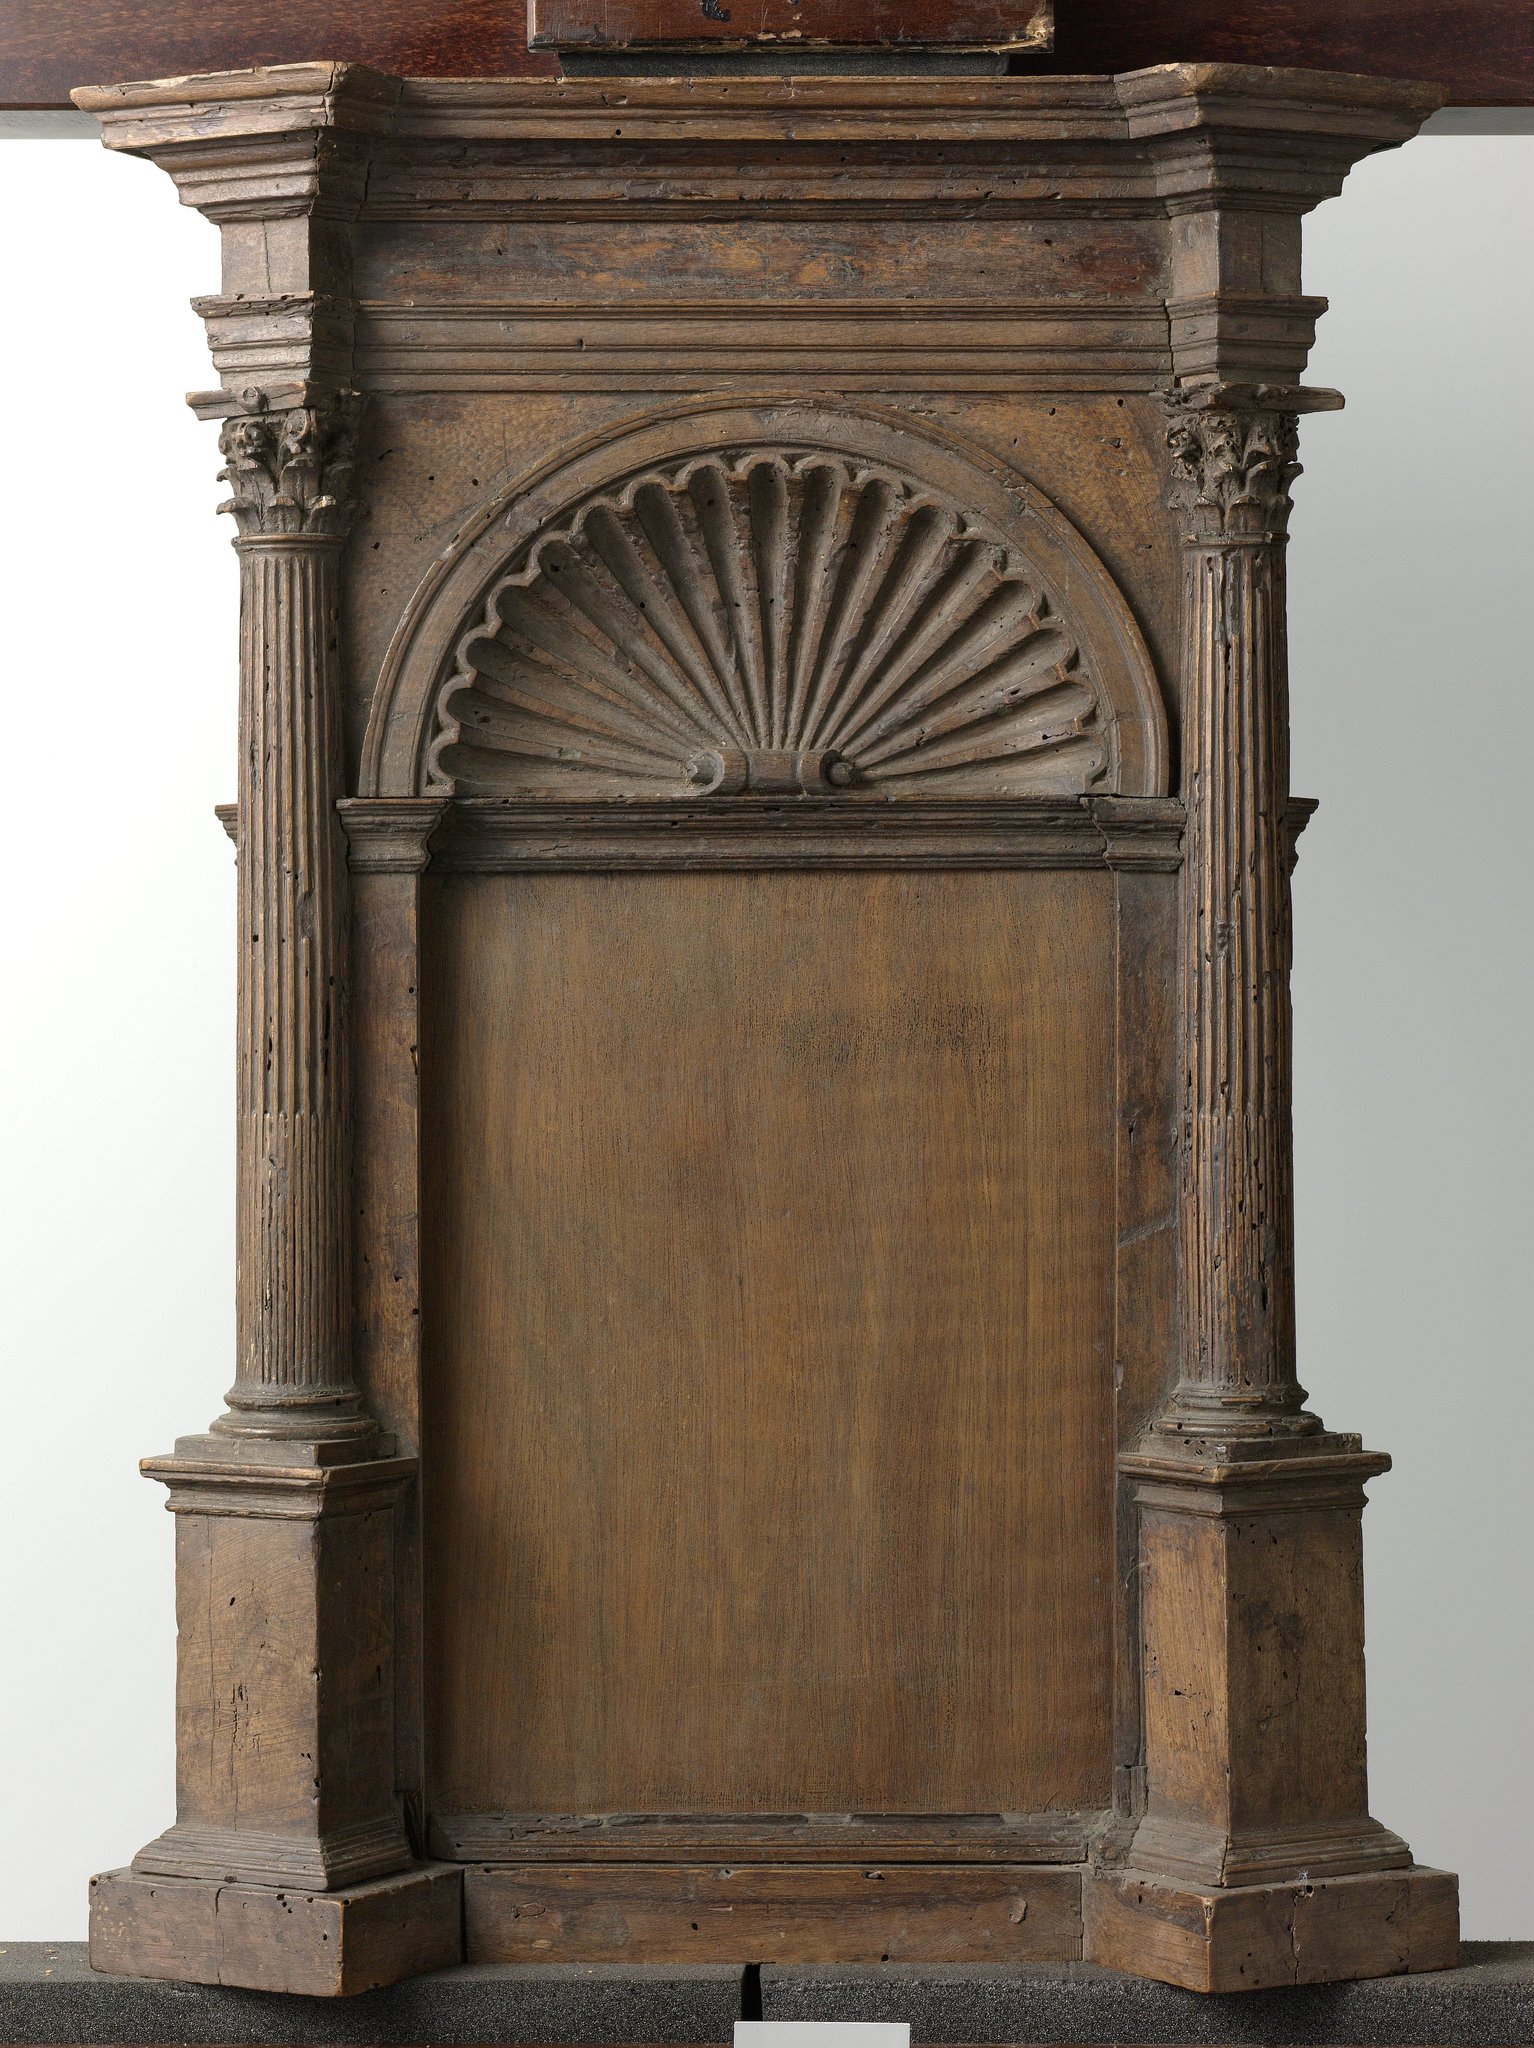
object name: betimmering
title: Betimmering, met overhoeks geplaatste Corinthische zuilen op piedestals, waartussen een randboog gedragen door pilasters, gevuld met schelp (fragment)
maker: Anonymous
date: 1500-1600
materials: wood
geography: france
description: Betimmering van notenhout, bestaande uit twee paneelomlijstingen. Deze bestaan uit een hoofdgestel, rustende op twee overhoeks geplaatste Corinthische gecanneleerde zuilen op piedestals. Hiertussen bevindt zich een randboog, gedragen door pilasters en gevuld met een schelp.